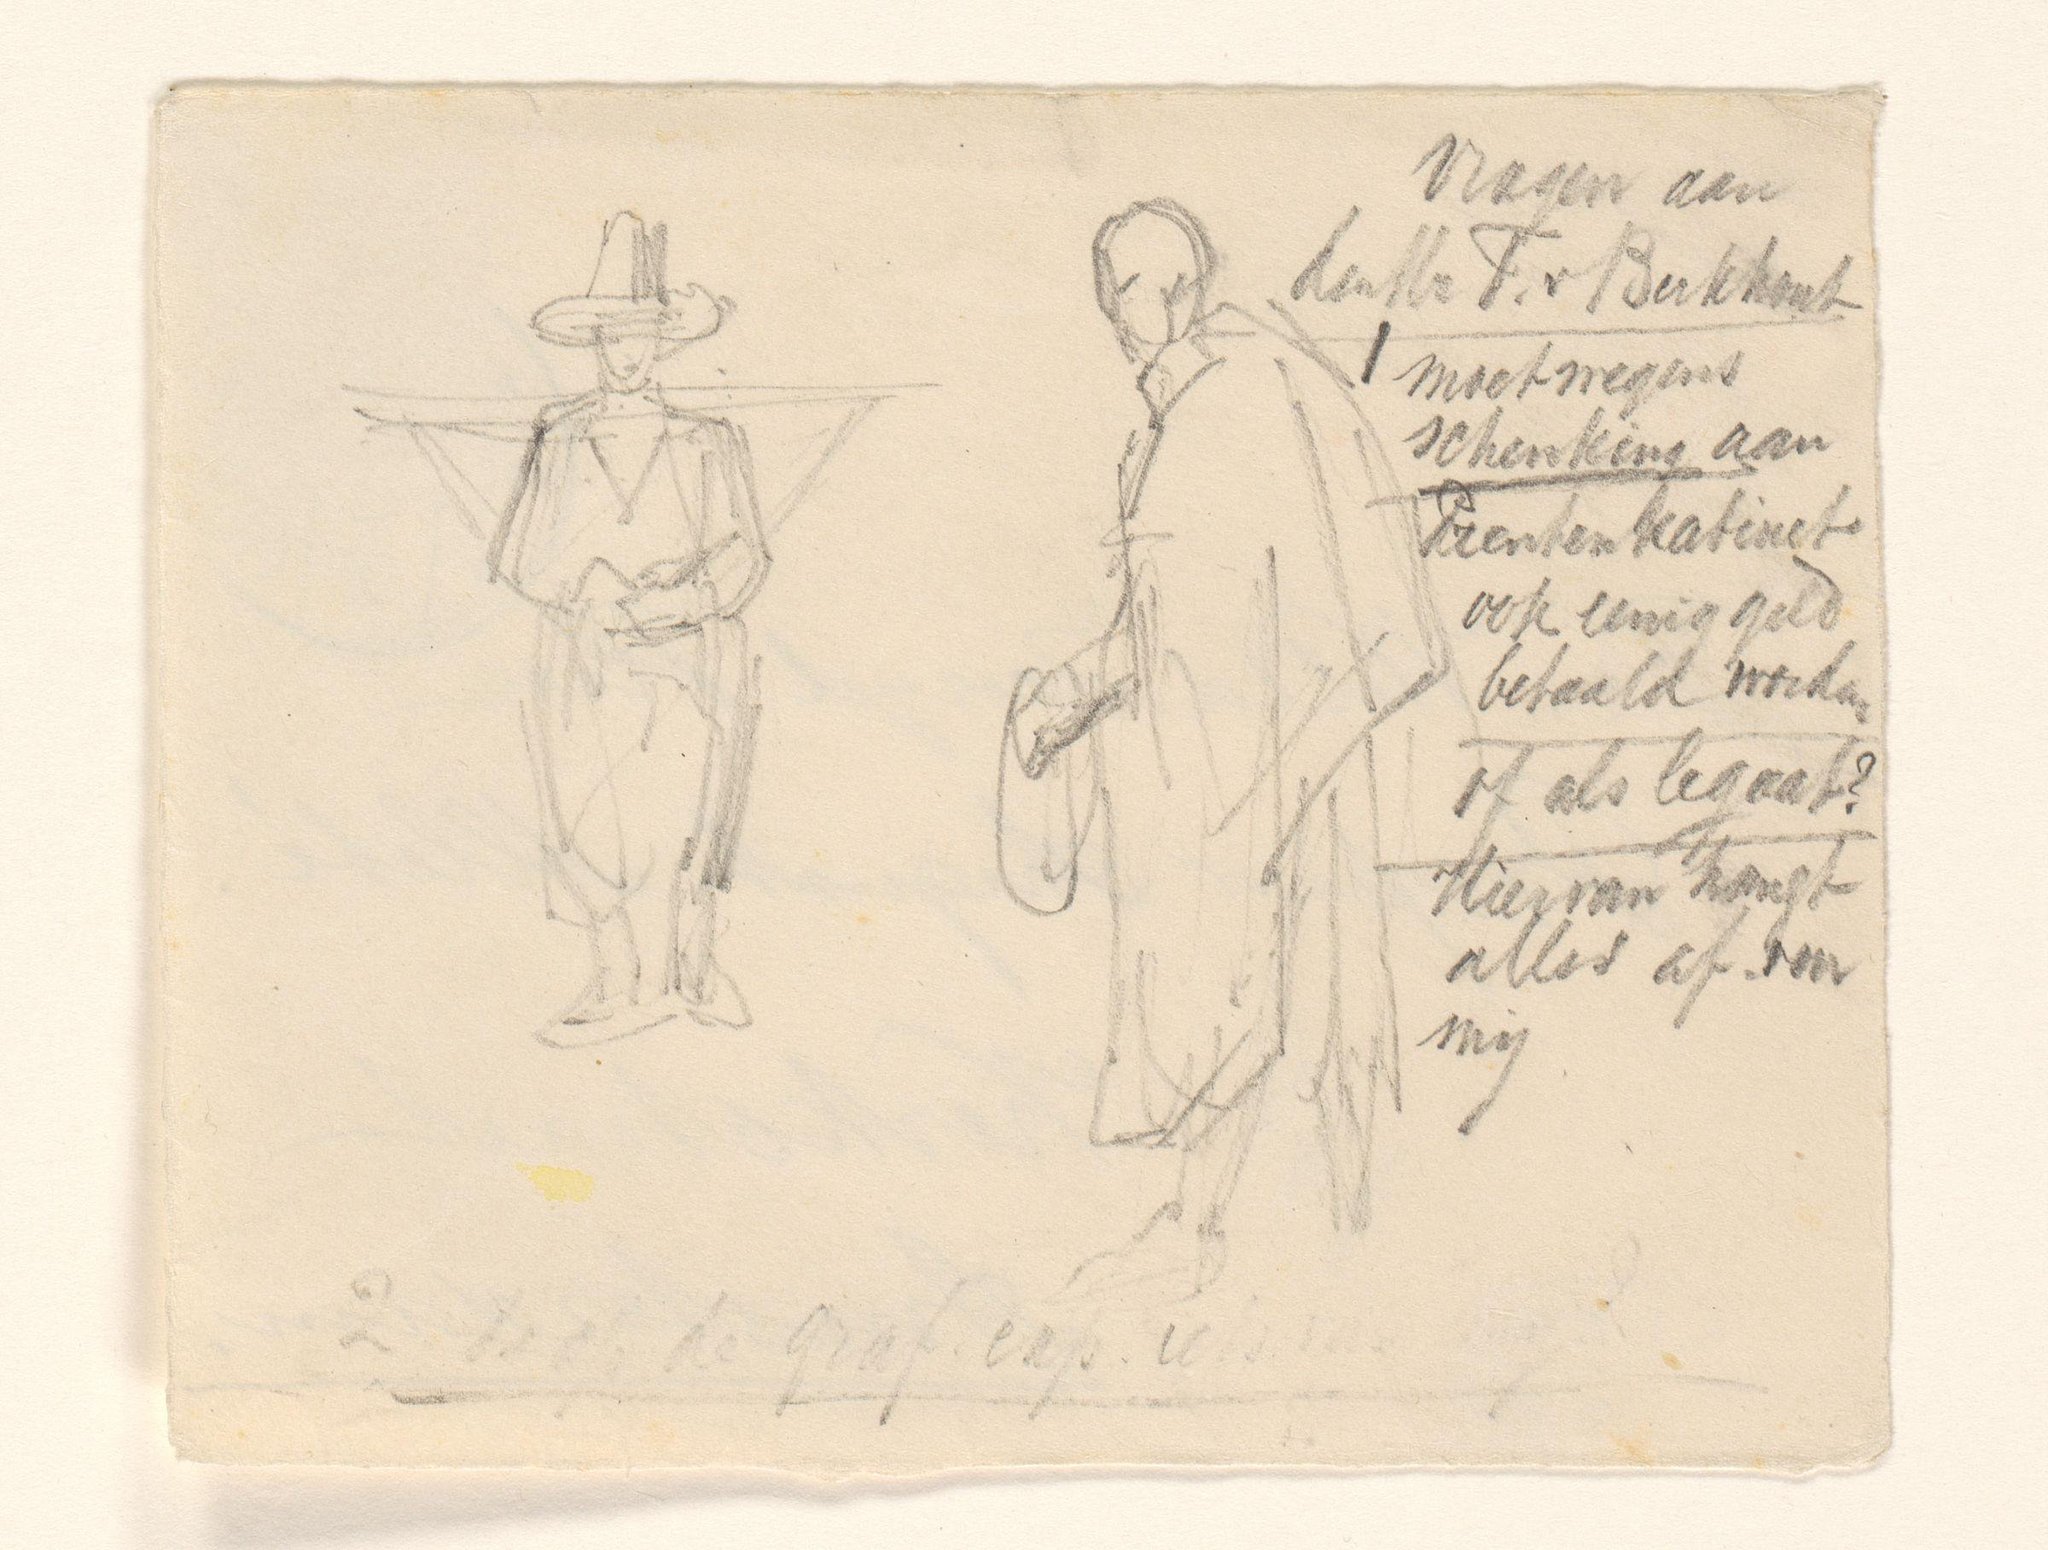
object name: envelope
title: Schetsblad met figuurstudies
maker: august allebé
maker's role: draughtsman, print maker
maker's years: 1838-1927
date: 1848-1927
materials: paper, pencil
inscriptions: inscription